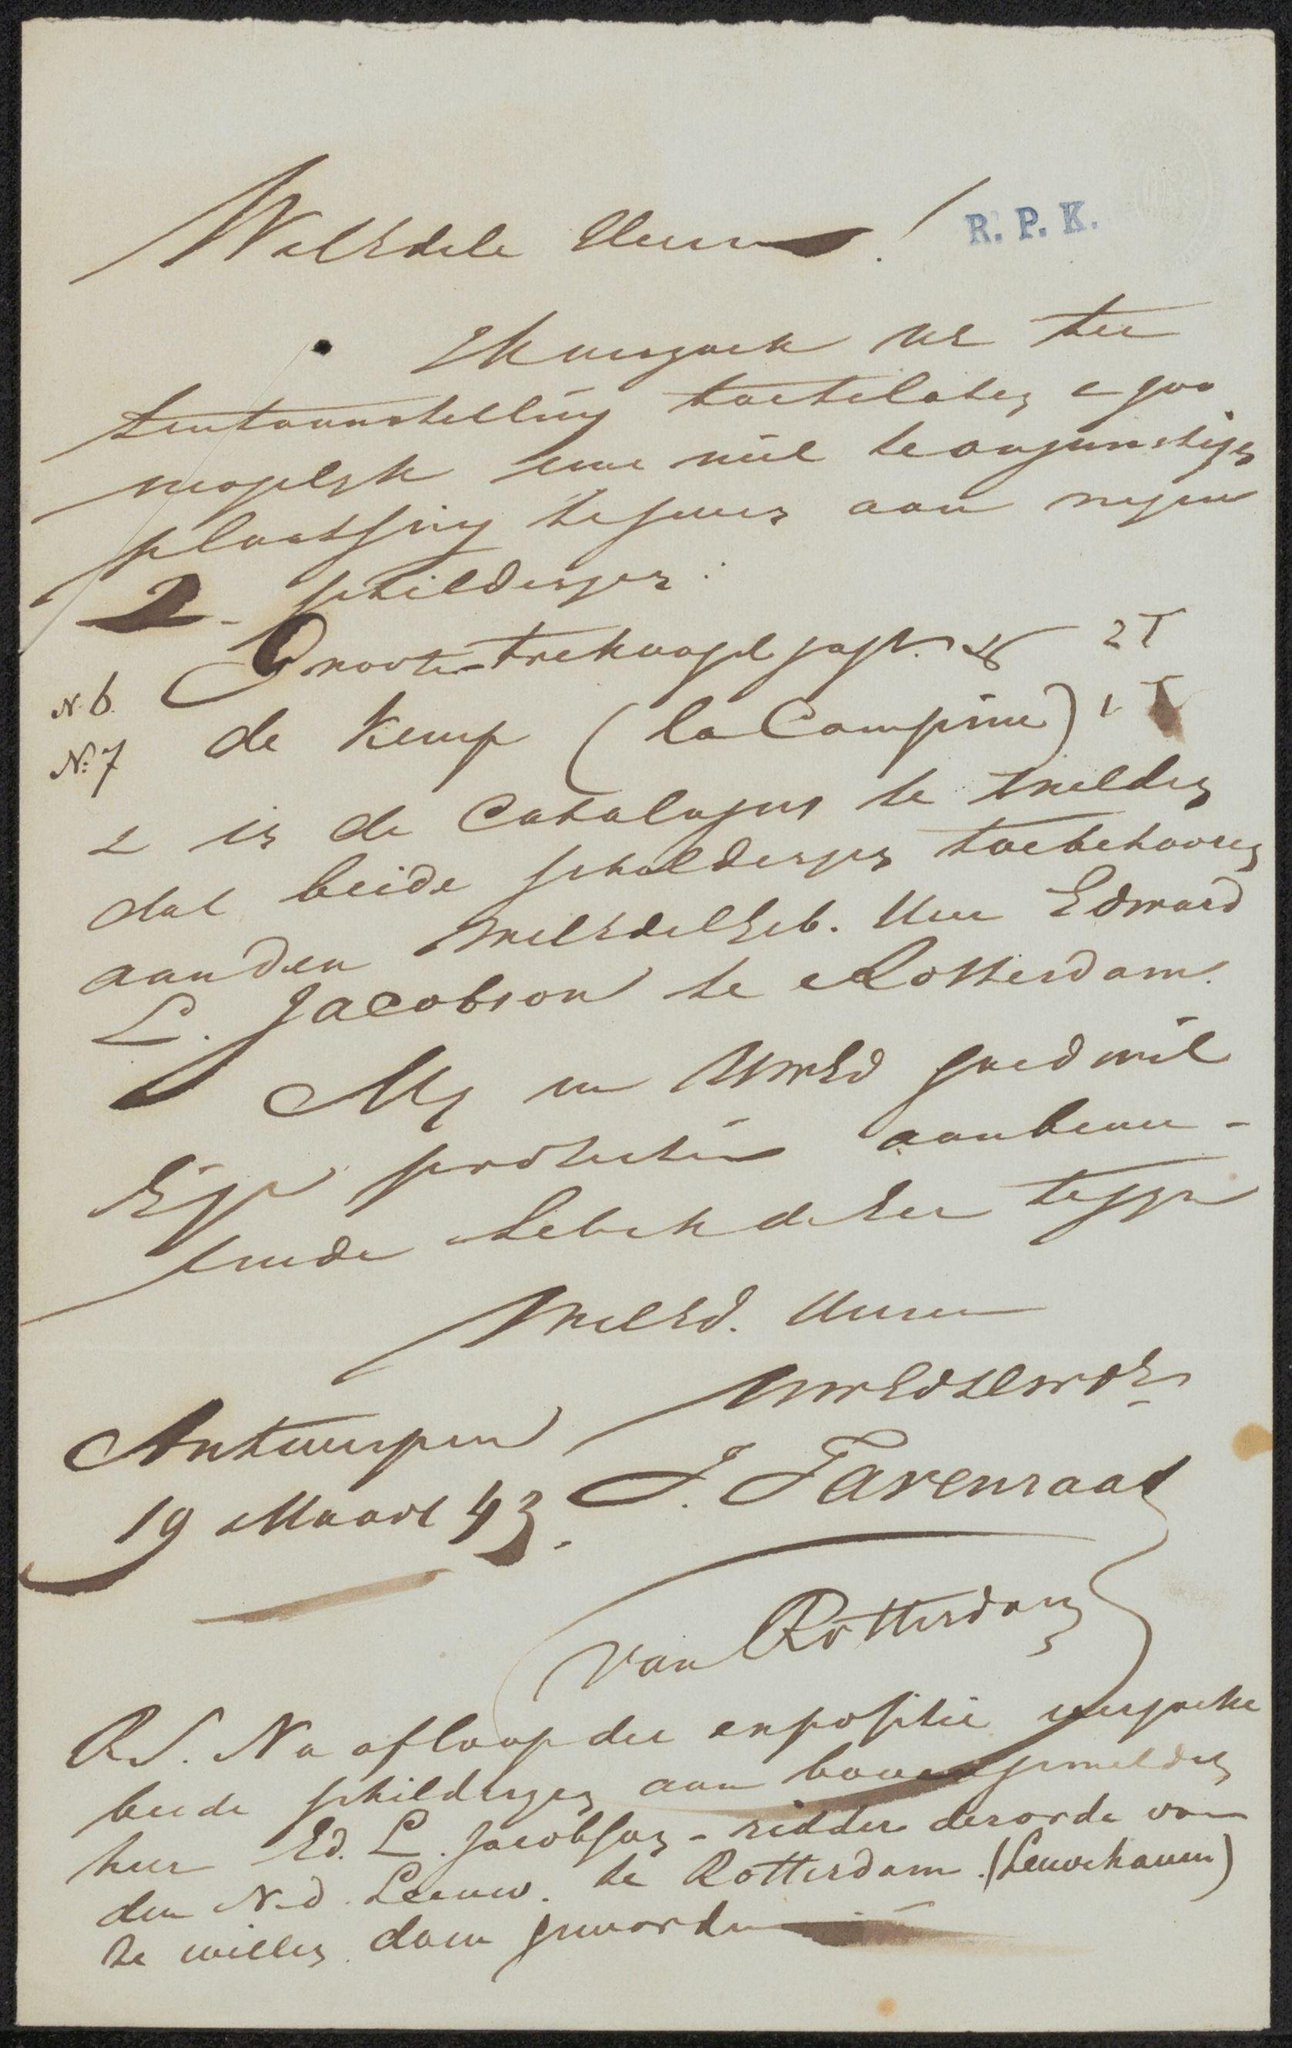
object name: letter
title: Brief aan de commissie van de Tentoonstelling van Levende Meesters in Den Haag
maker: johannes tavenraat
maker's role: draughtsman, painter, print maker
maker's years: 1809-1881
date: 1843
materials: ink, paper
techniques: pen, writing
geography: antwerp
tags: painting (including book-illumination, miniature-painting), exhibition ~ art, art collecting, rotterdam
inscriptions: collector's mark: Lugt 2233